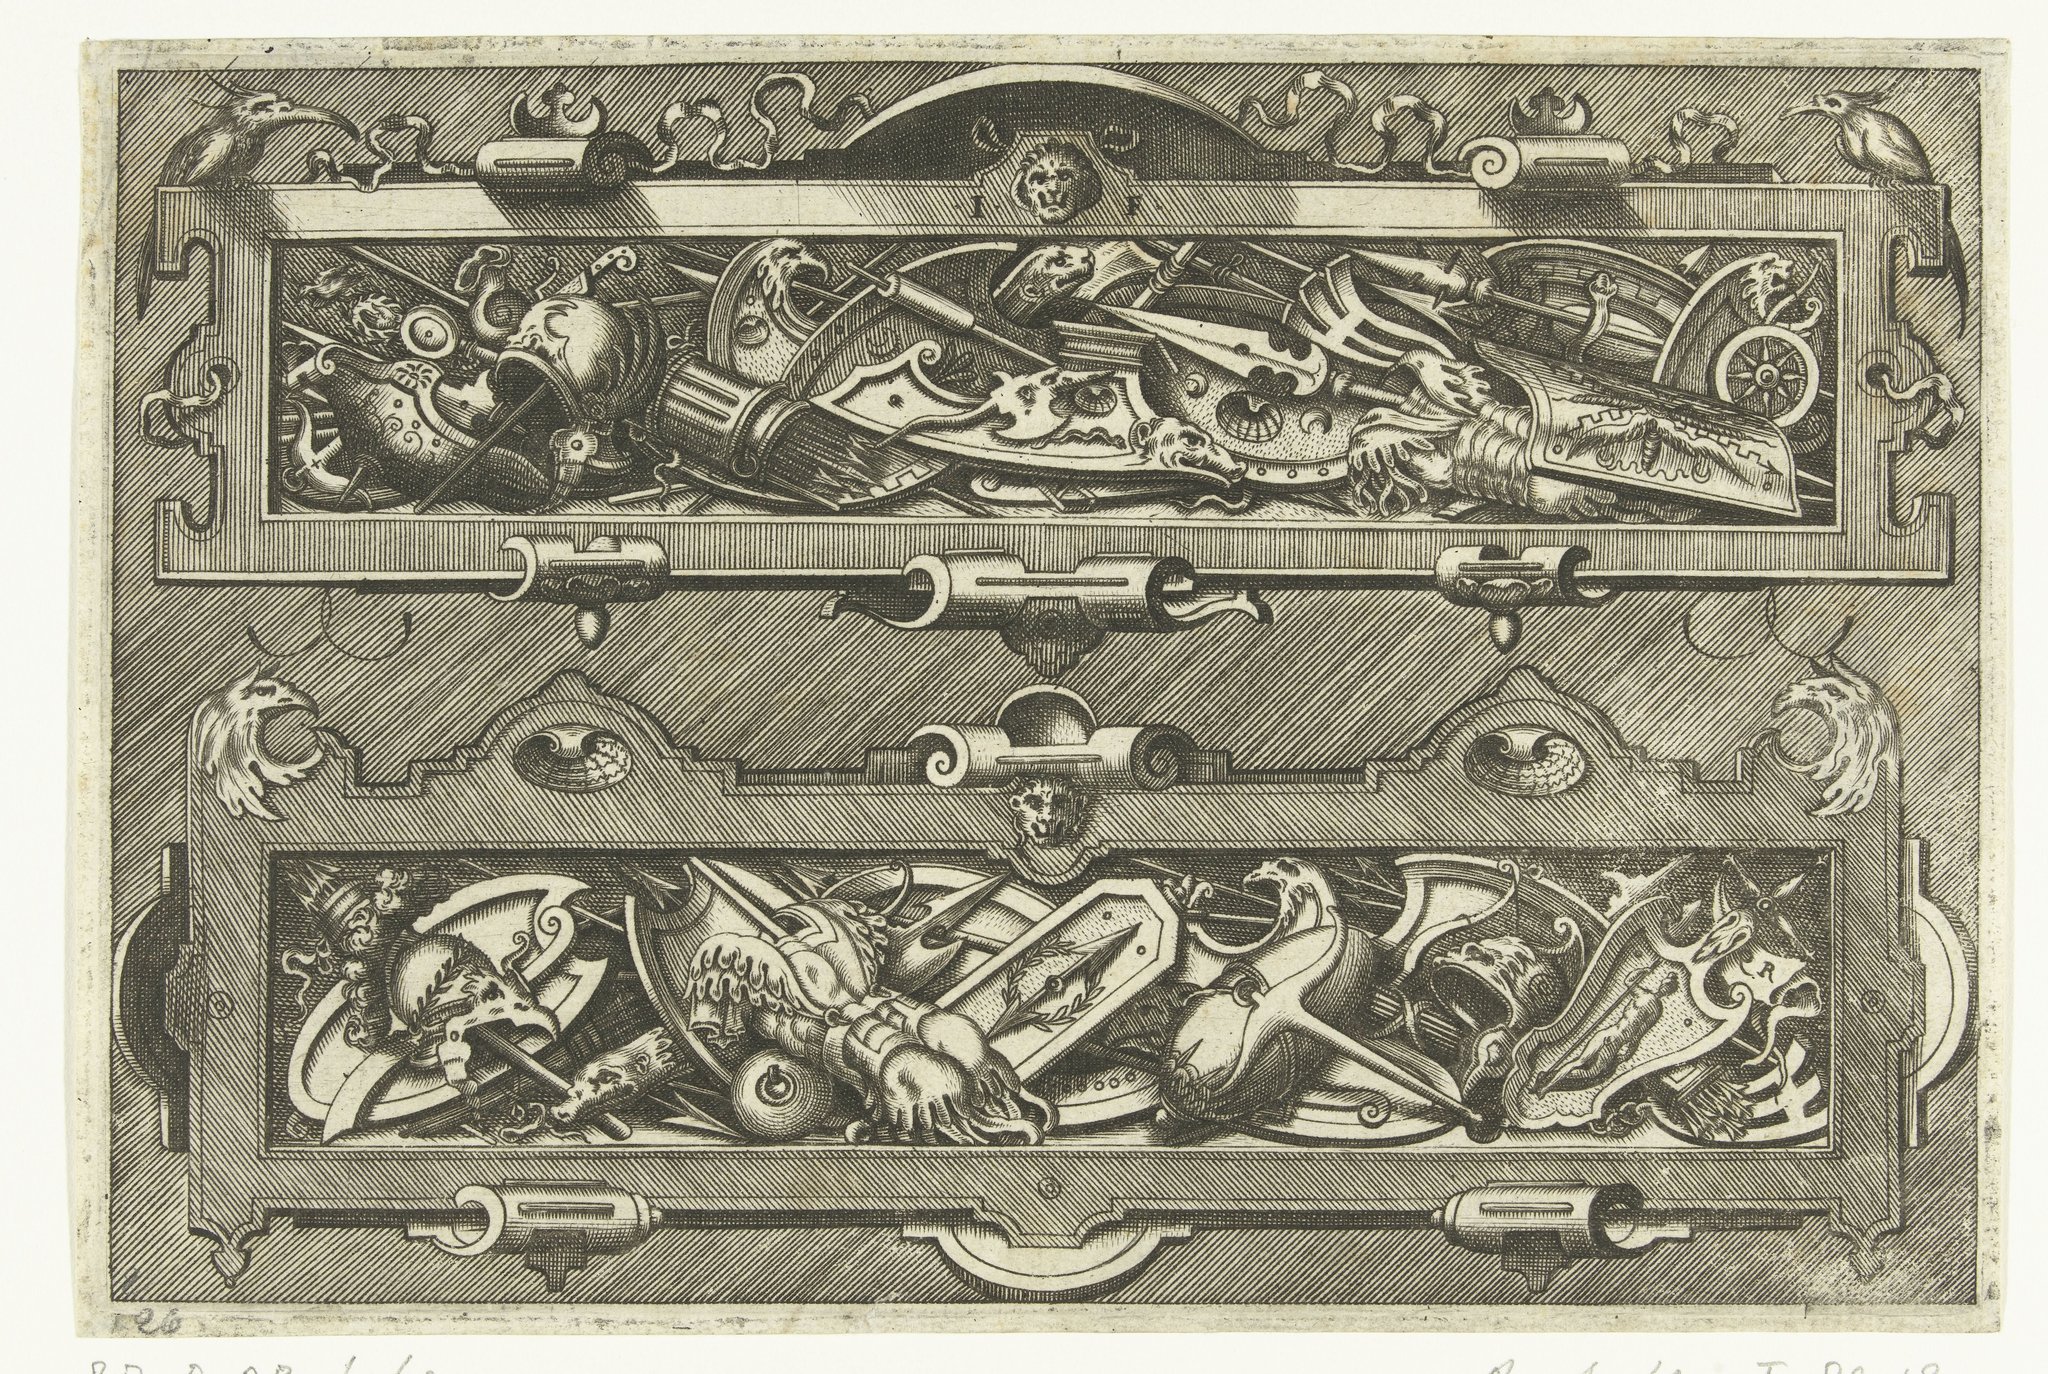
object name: ornament print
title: Compertimenta pictoriis flosculis manubiisque…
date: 1567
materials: paper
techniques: engraving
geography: netherlands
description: Op de hoeken van het bovenste fries zitten twee vogels. Gearceerde achtergrond. Hoort bij serie van 14 bladen cartouches met rolwerk, grotesken, trofeeën en friezen. Het titelblad ontbreekt.